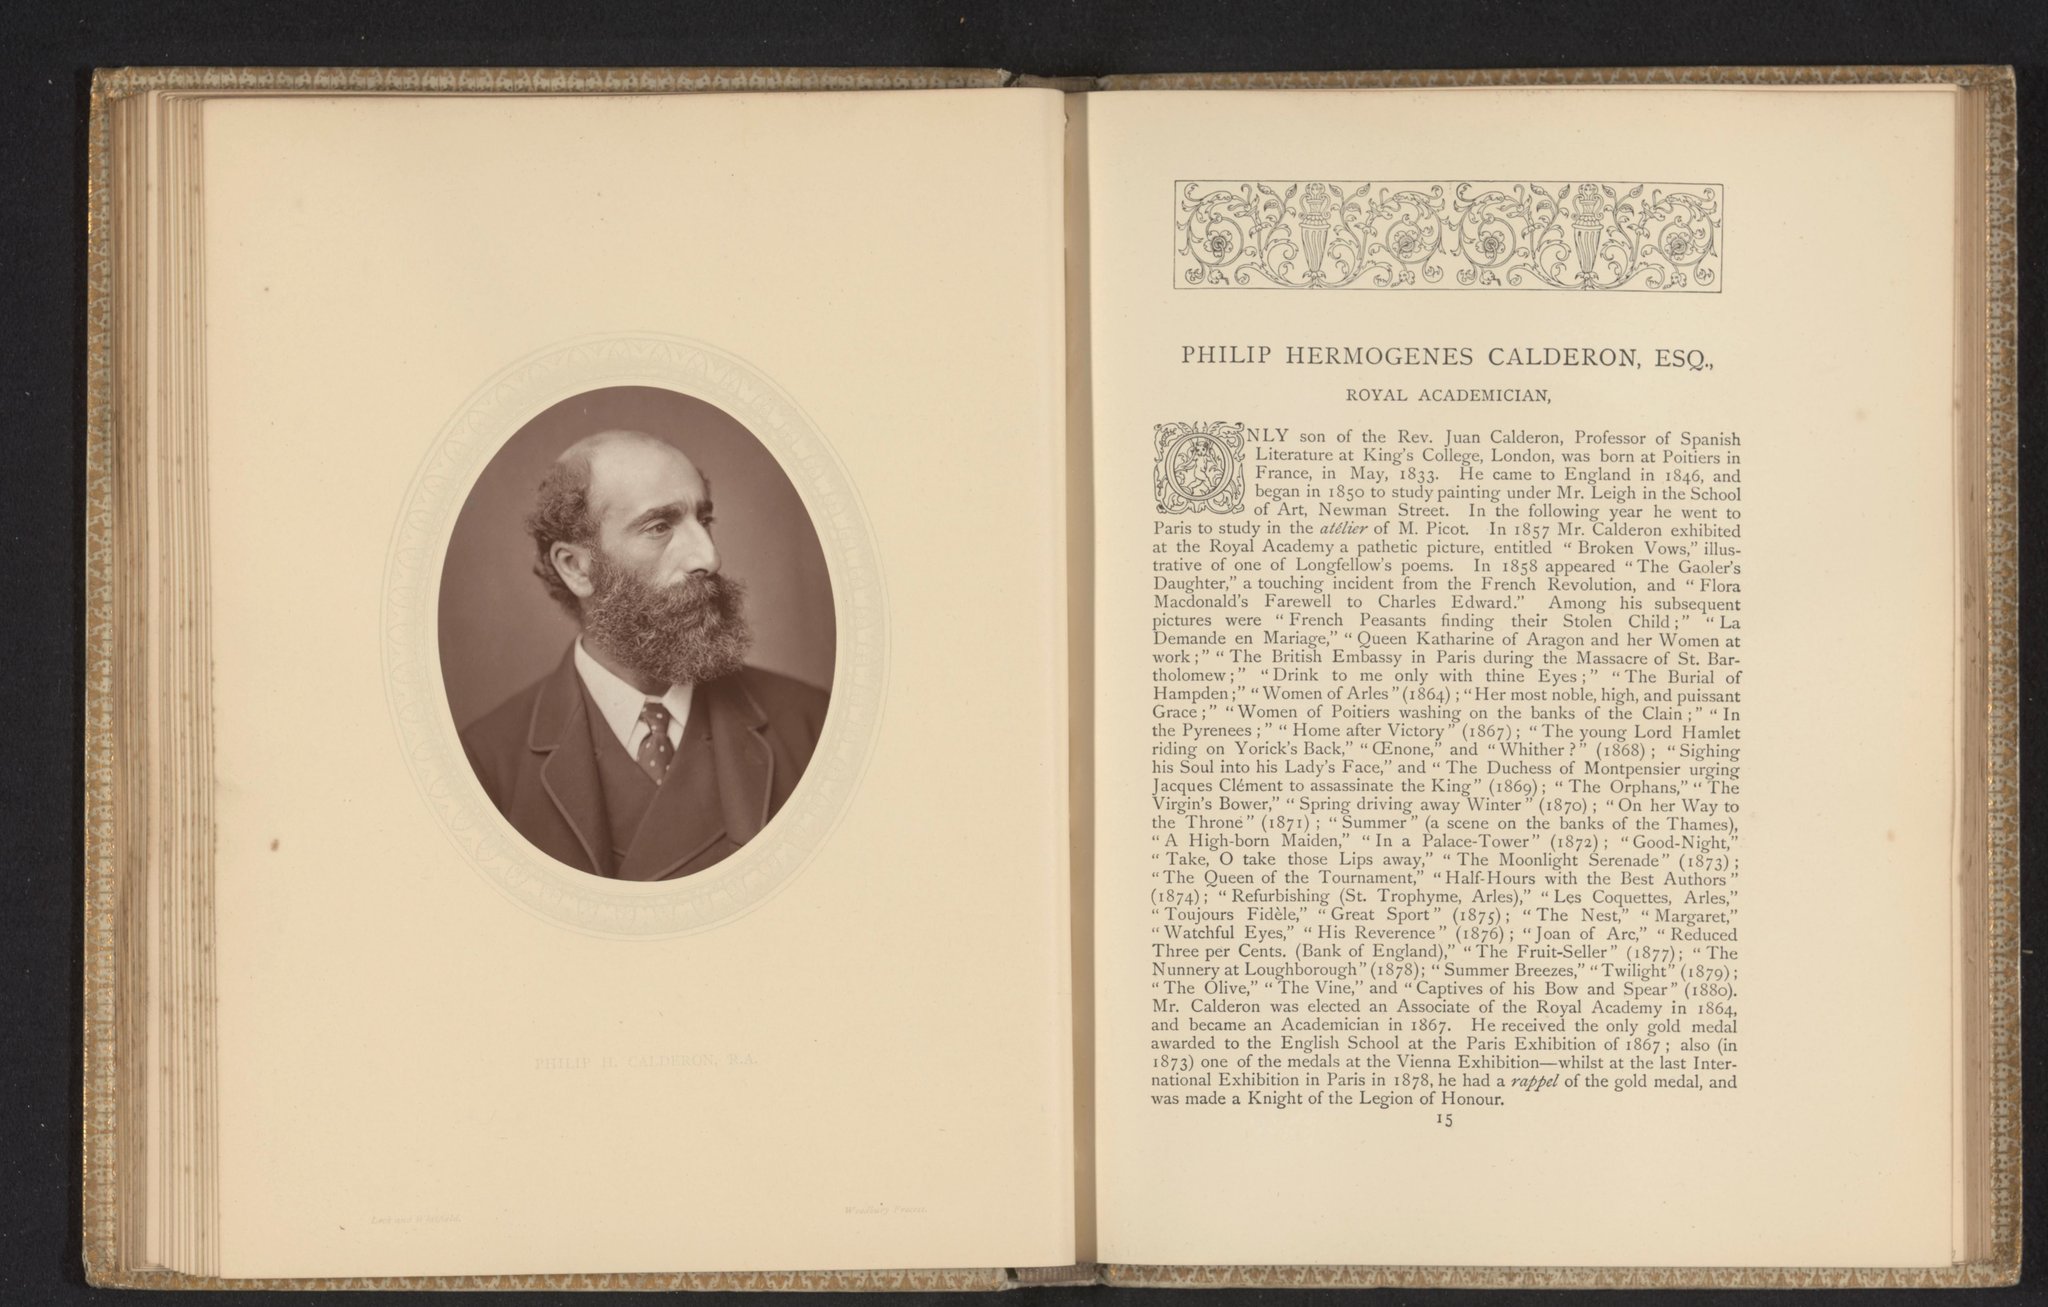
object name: photomechanical print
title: Philip H. Calderon, R.A.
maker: Anonymous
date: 1877-1882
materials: paper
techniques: woodburytype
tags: painter, portrait, self-portrait of painter, historical persons (portraits and scenes from the life) (+ (full) bust portrait)